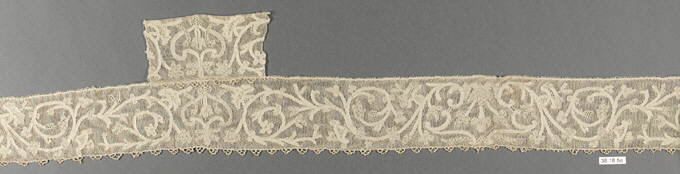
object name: hebrew ritual lace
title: Hebrew ritual lace (one of four)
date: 1701-1733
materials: silk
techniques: lace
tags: ritual objects